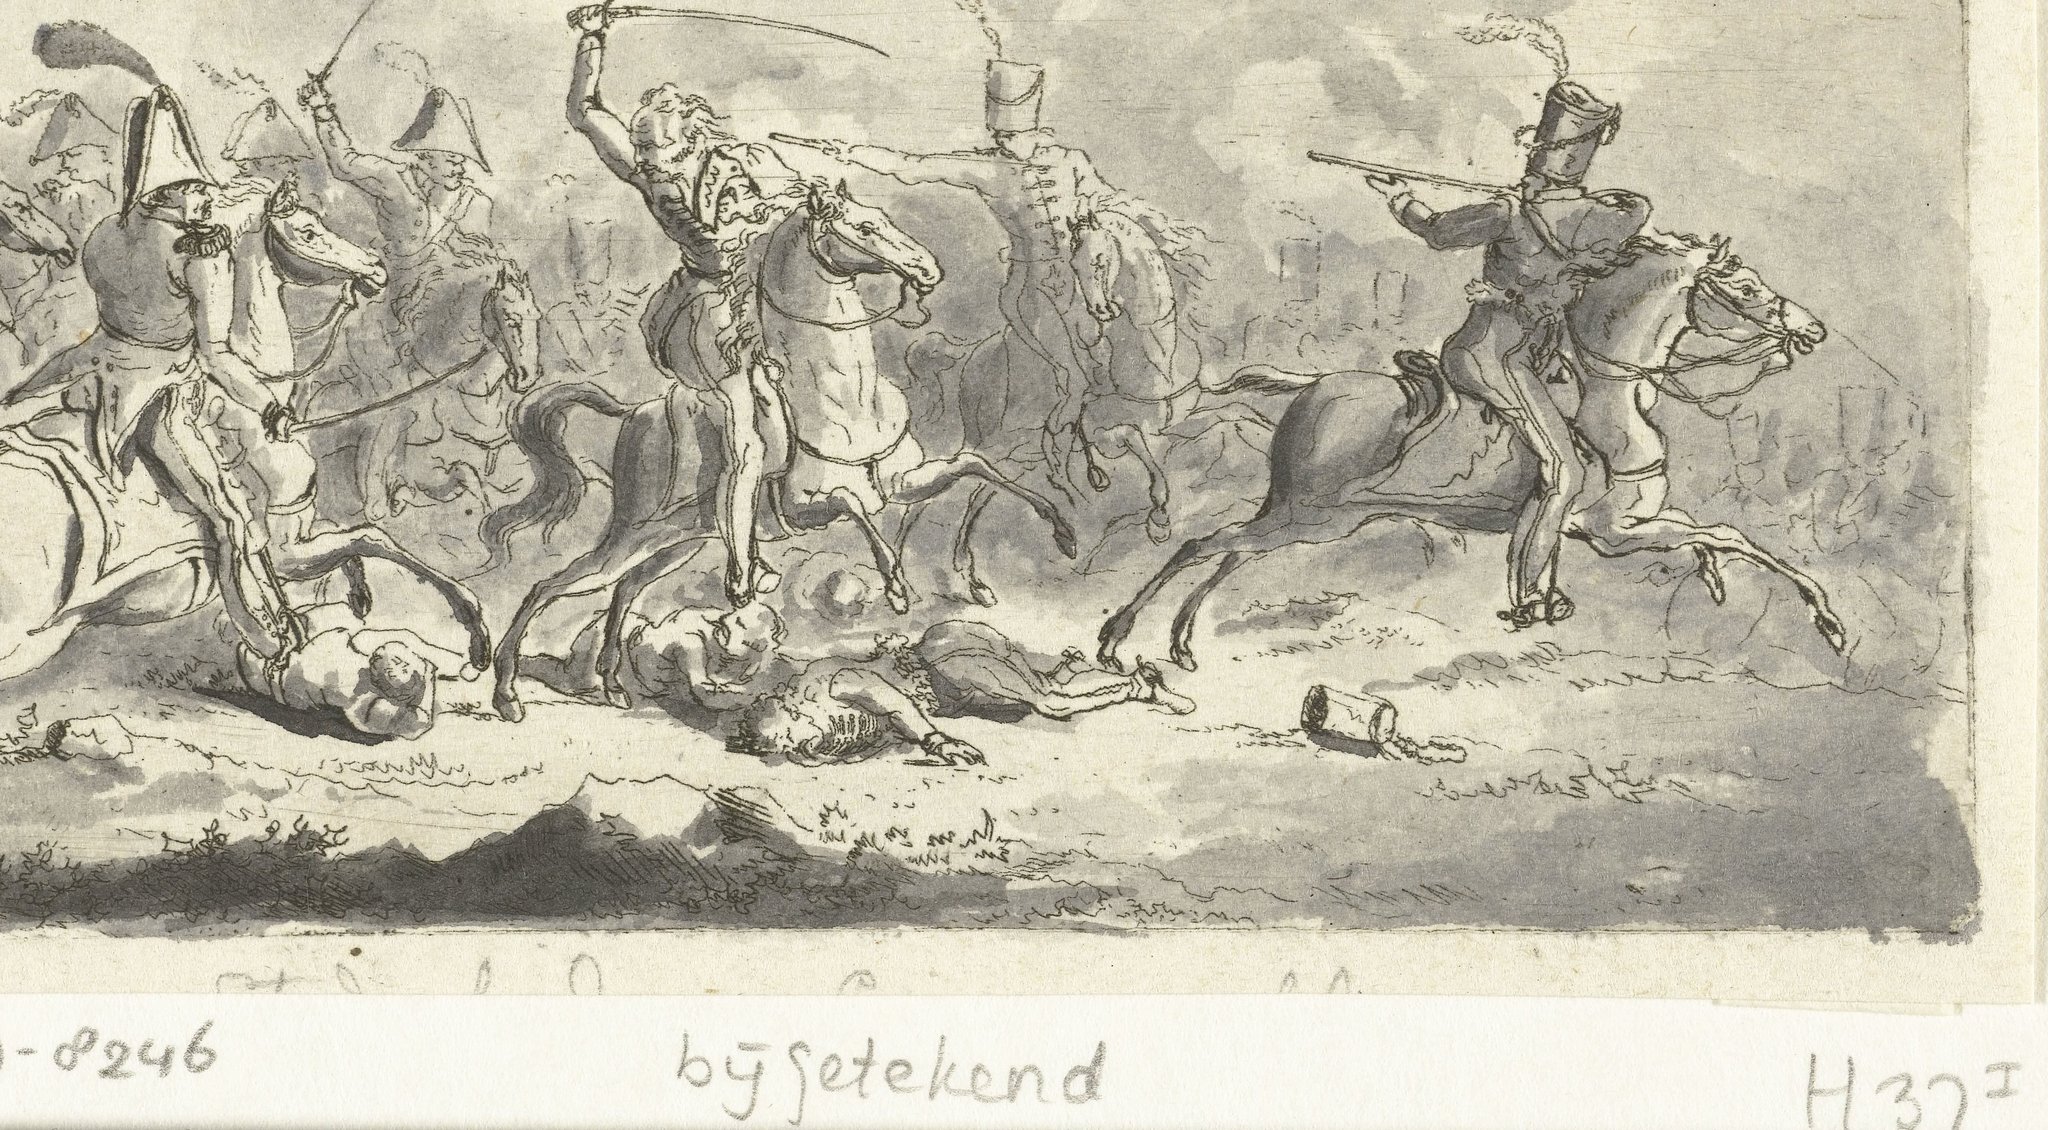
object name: print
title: Cavalerie tijdens een veldslag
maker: gerardus emaus de micault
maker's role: draughtsman, print maker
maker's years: 1798-1863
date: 1813-1863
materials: paper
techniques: etching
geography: netherlands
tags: warfare; military affairs (+ cavalry, horsemen)